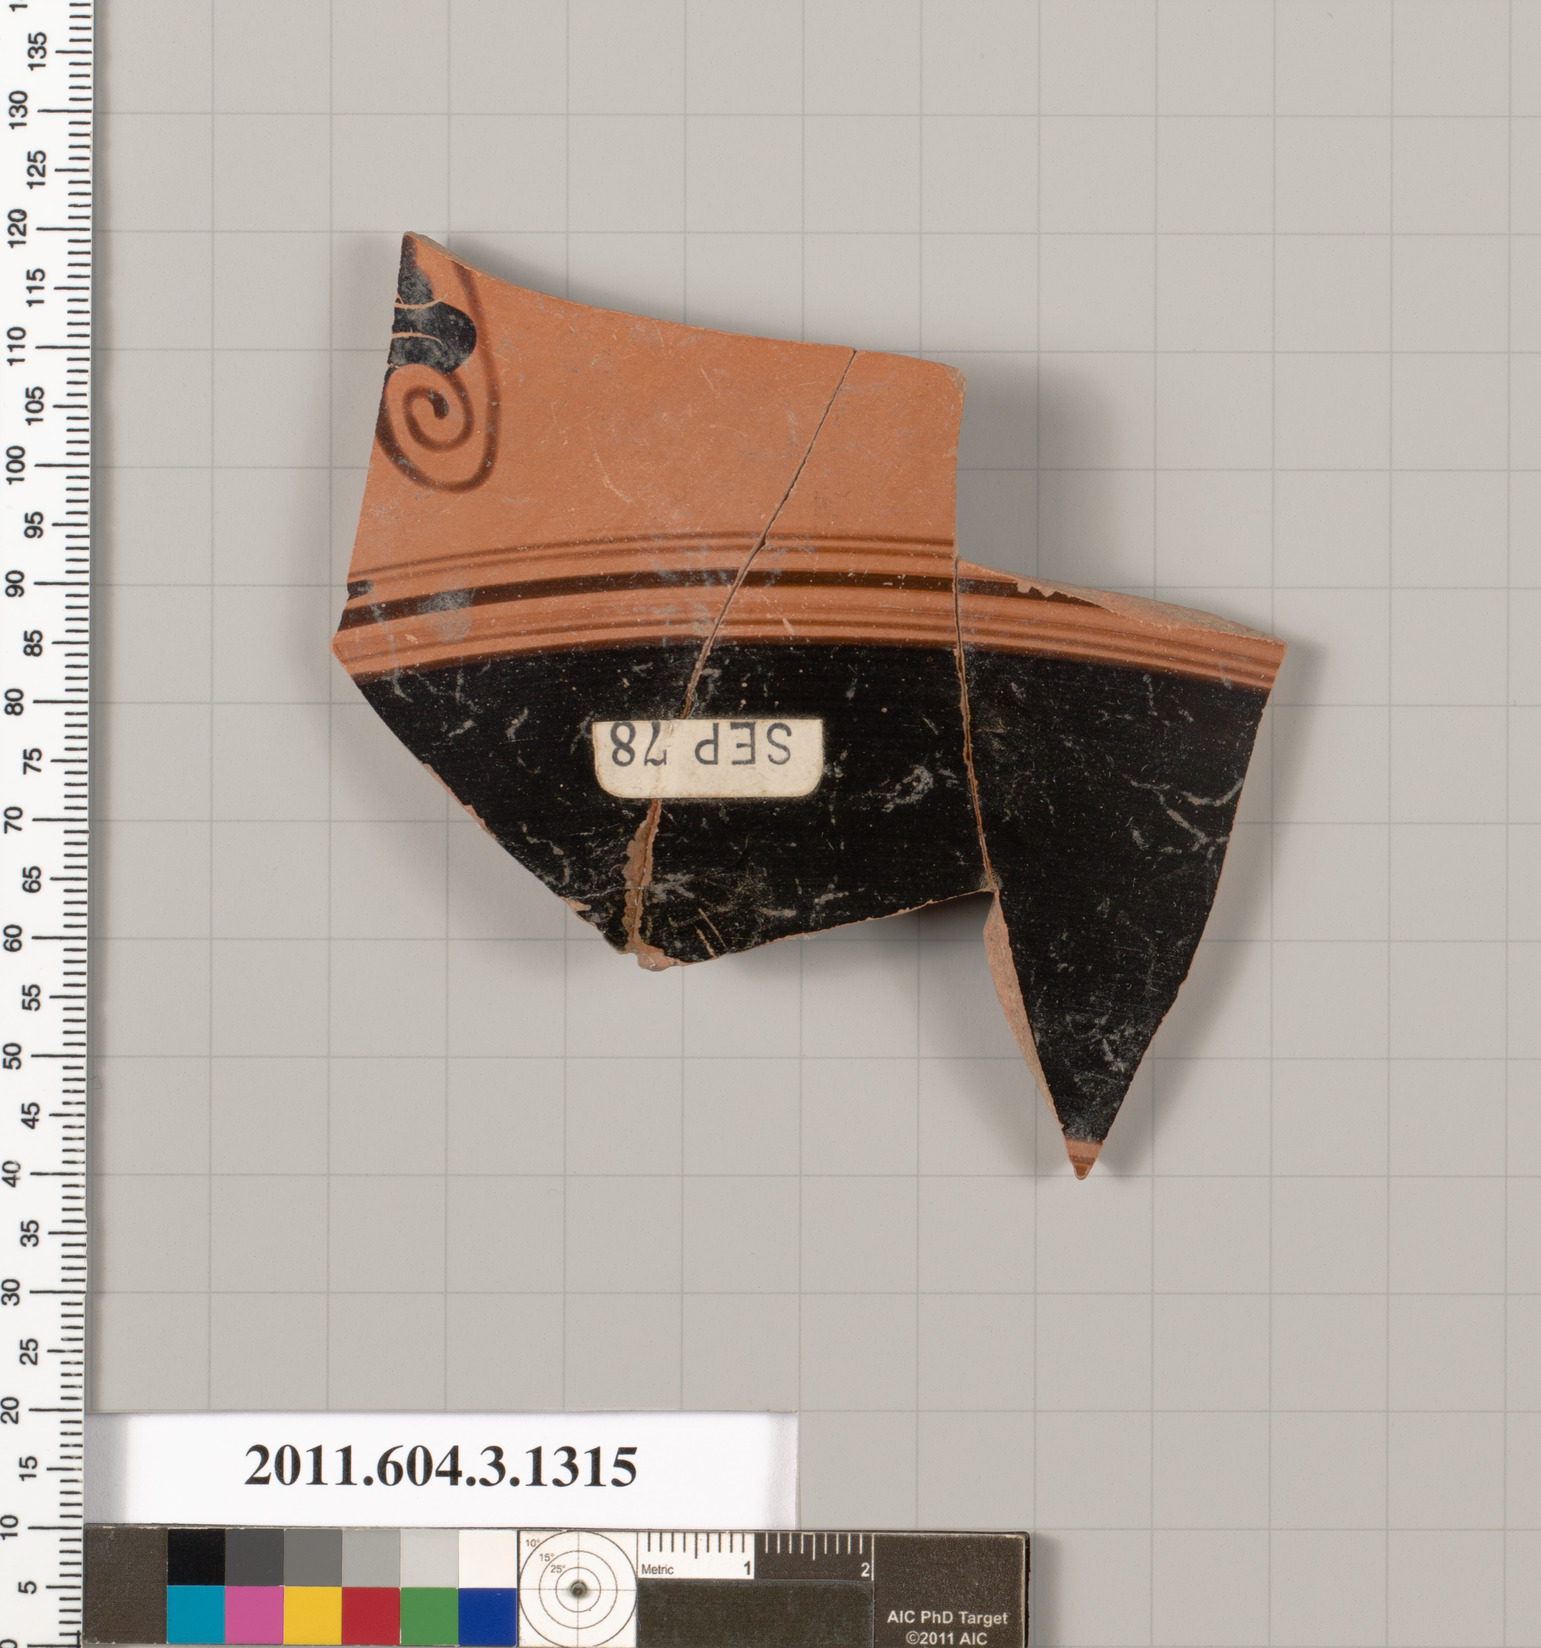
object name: skyphos fragment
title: Terracotta fragment of a skyphos (deep drinking cup)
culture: greek, attic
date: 490-480 BCE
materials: terracotta